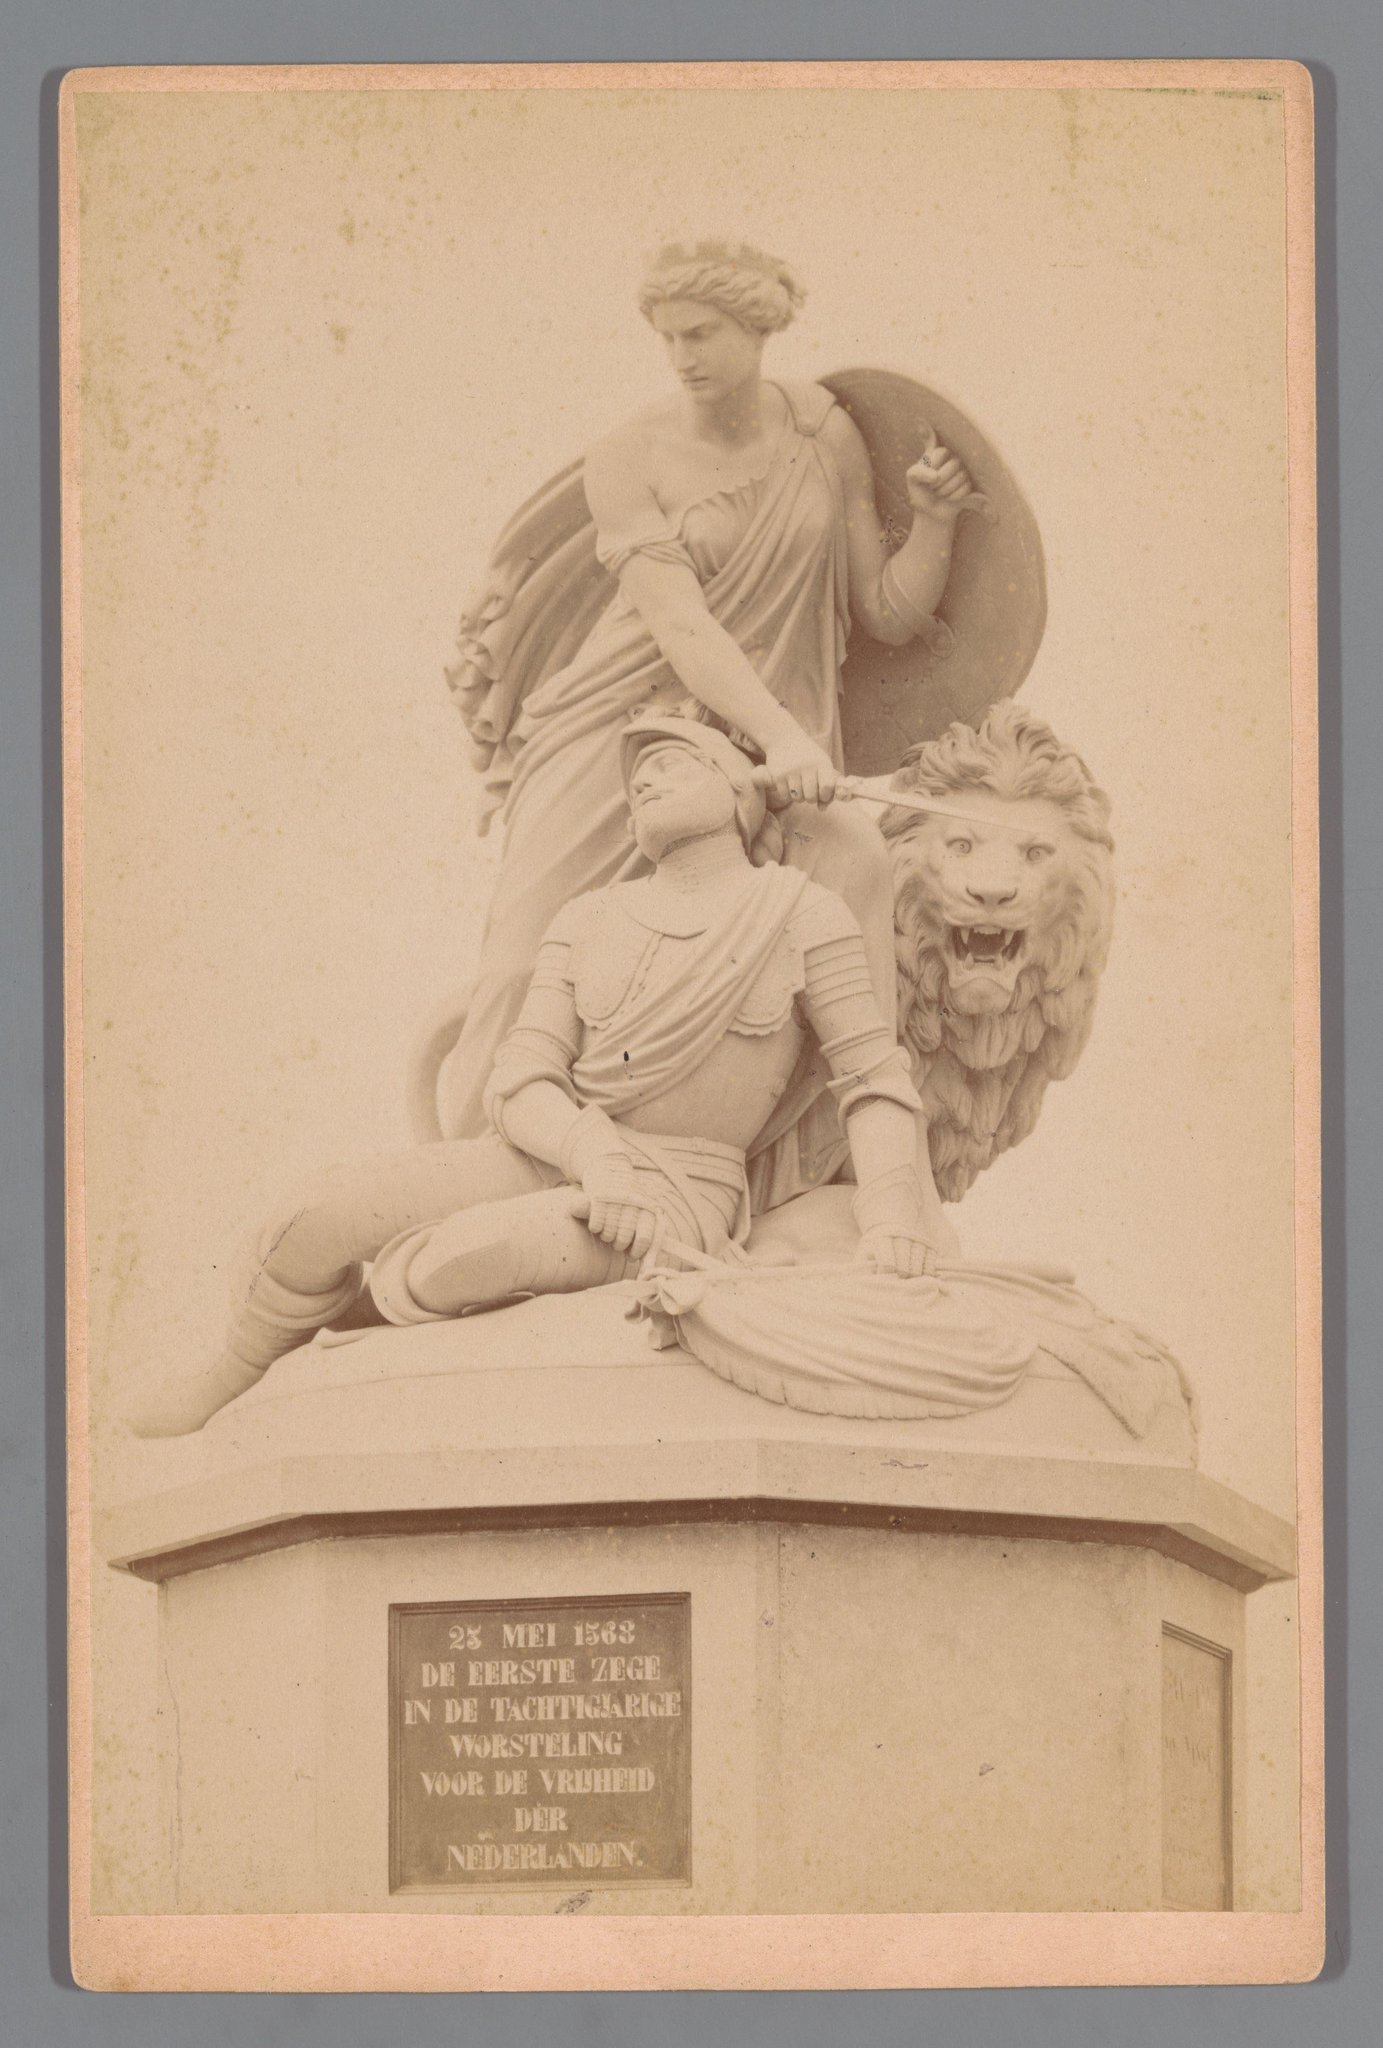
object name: photograph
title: Graaf Adolfmonument te Heiligerlee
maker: friedrich julius von kolkow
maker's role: fotograaf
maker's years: 1839-1914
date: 1880-1900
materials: cardboard, photographic support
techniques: albumen print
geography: heiligerlee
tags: monument, statue, dying, beasts of prey, predatory animals: lion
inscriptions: name: ‘Fr. Jul von Kolkow hof-fotograaf Groningen Groote Markt.’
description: Foto in papieren omslag met beschrijving.